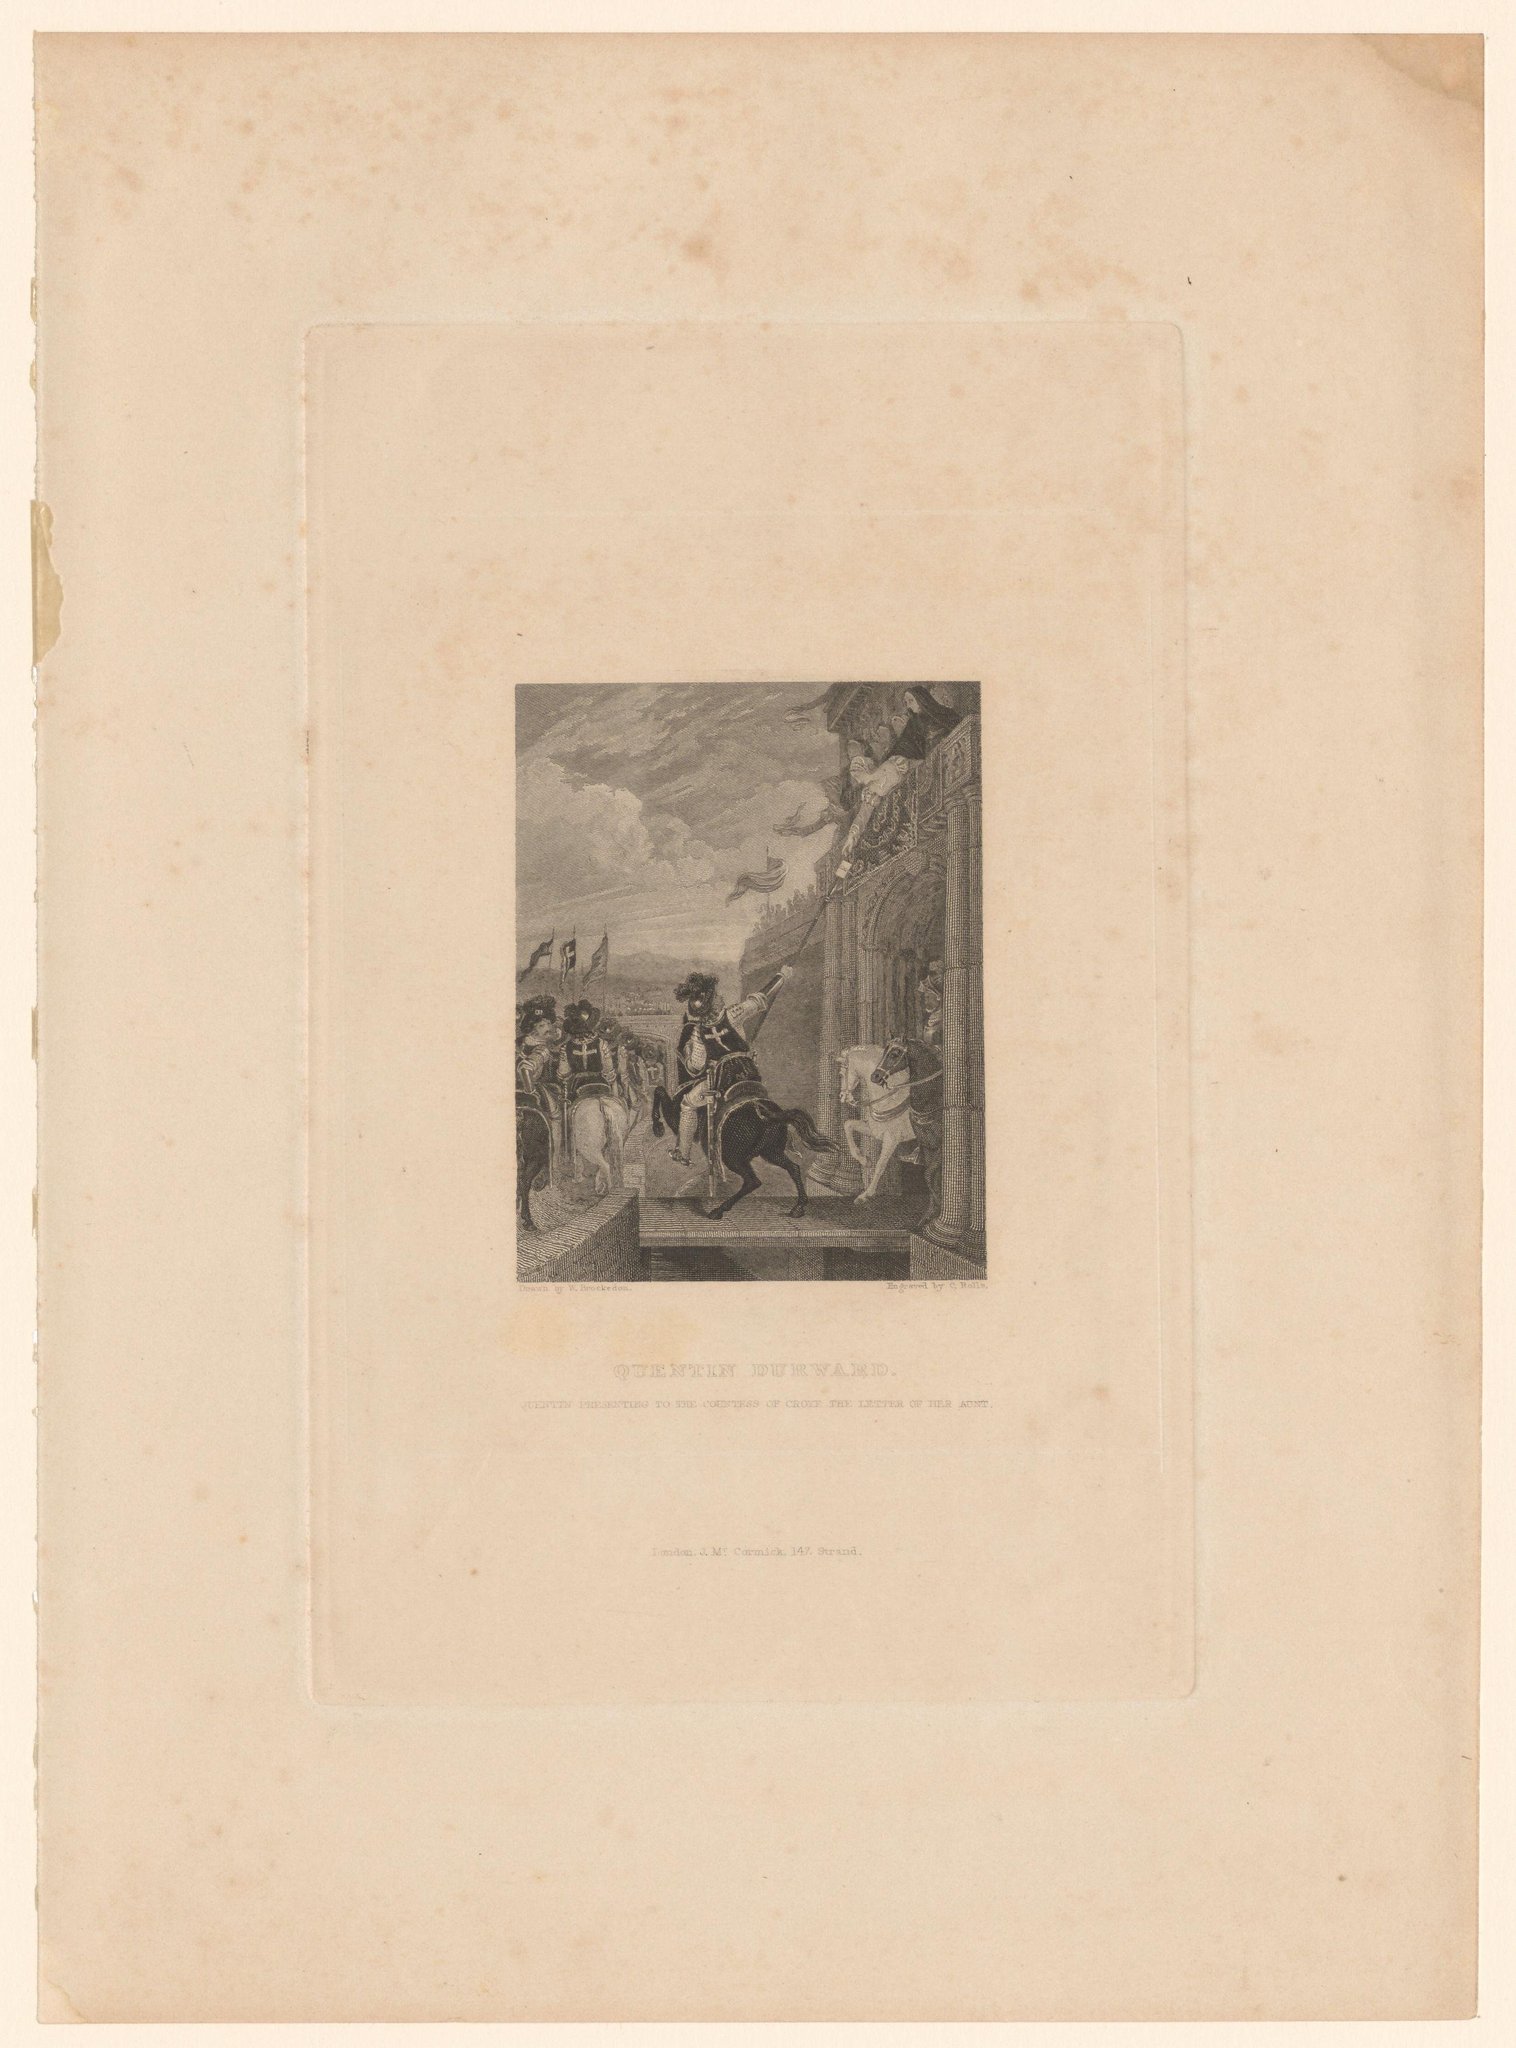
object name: print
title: Quentin Durward reikt de hertogin van Croye op het balkon de brief van haar tante aan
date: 1831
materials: paper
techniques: engraving, etching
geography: london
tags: letter, envelope, knight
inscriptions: collector's mark: Lugt 2228